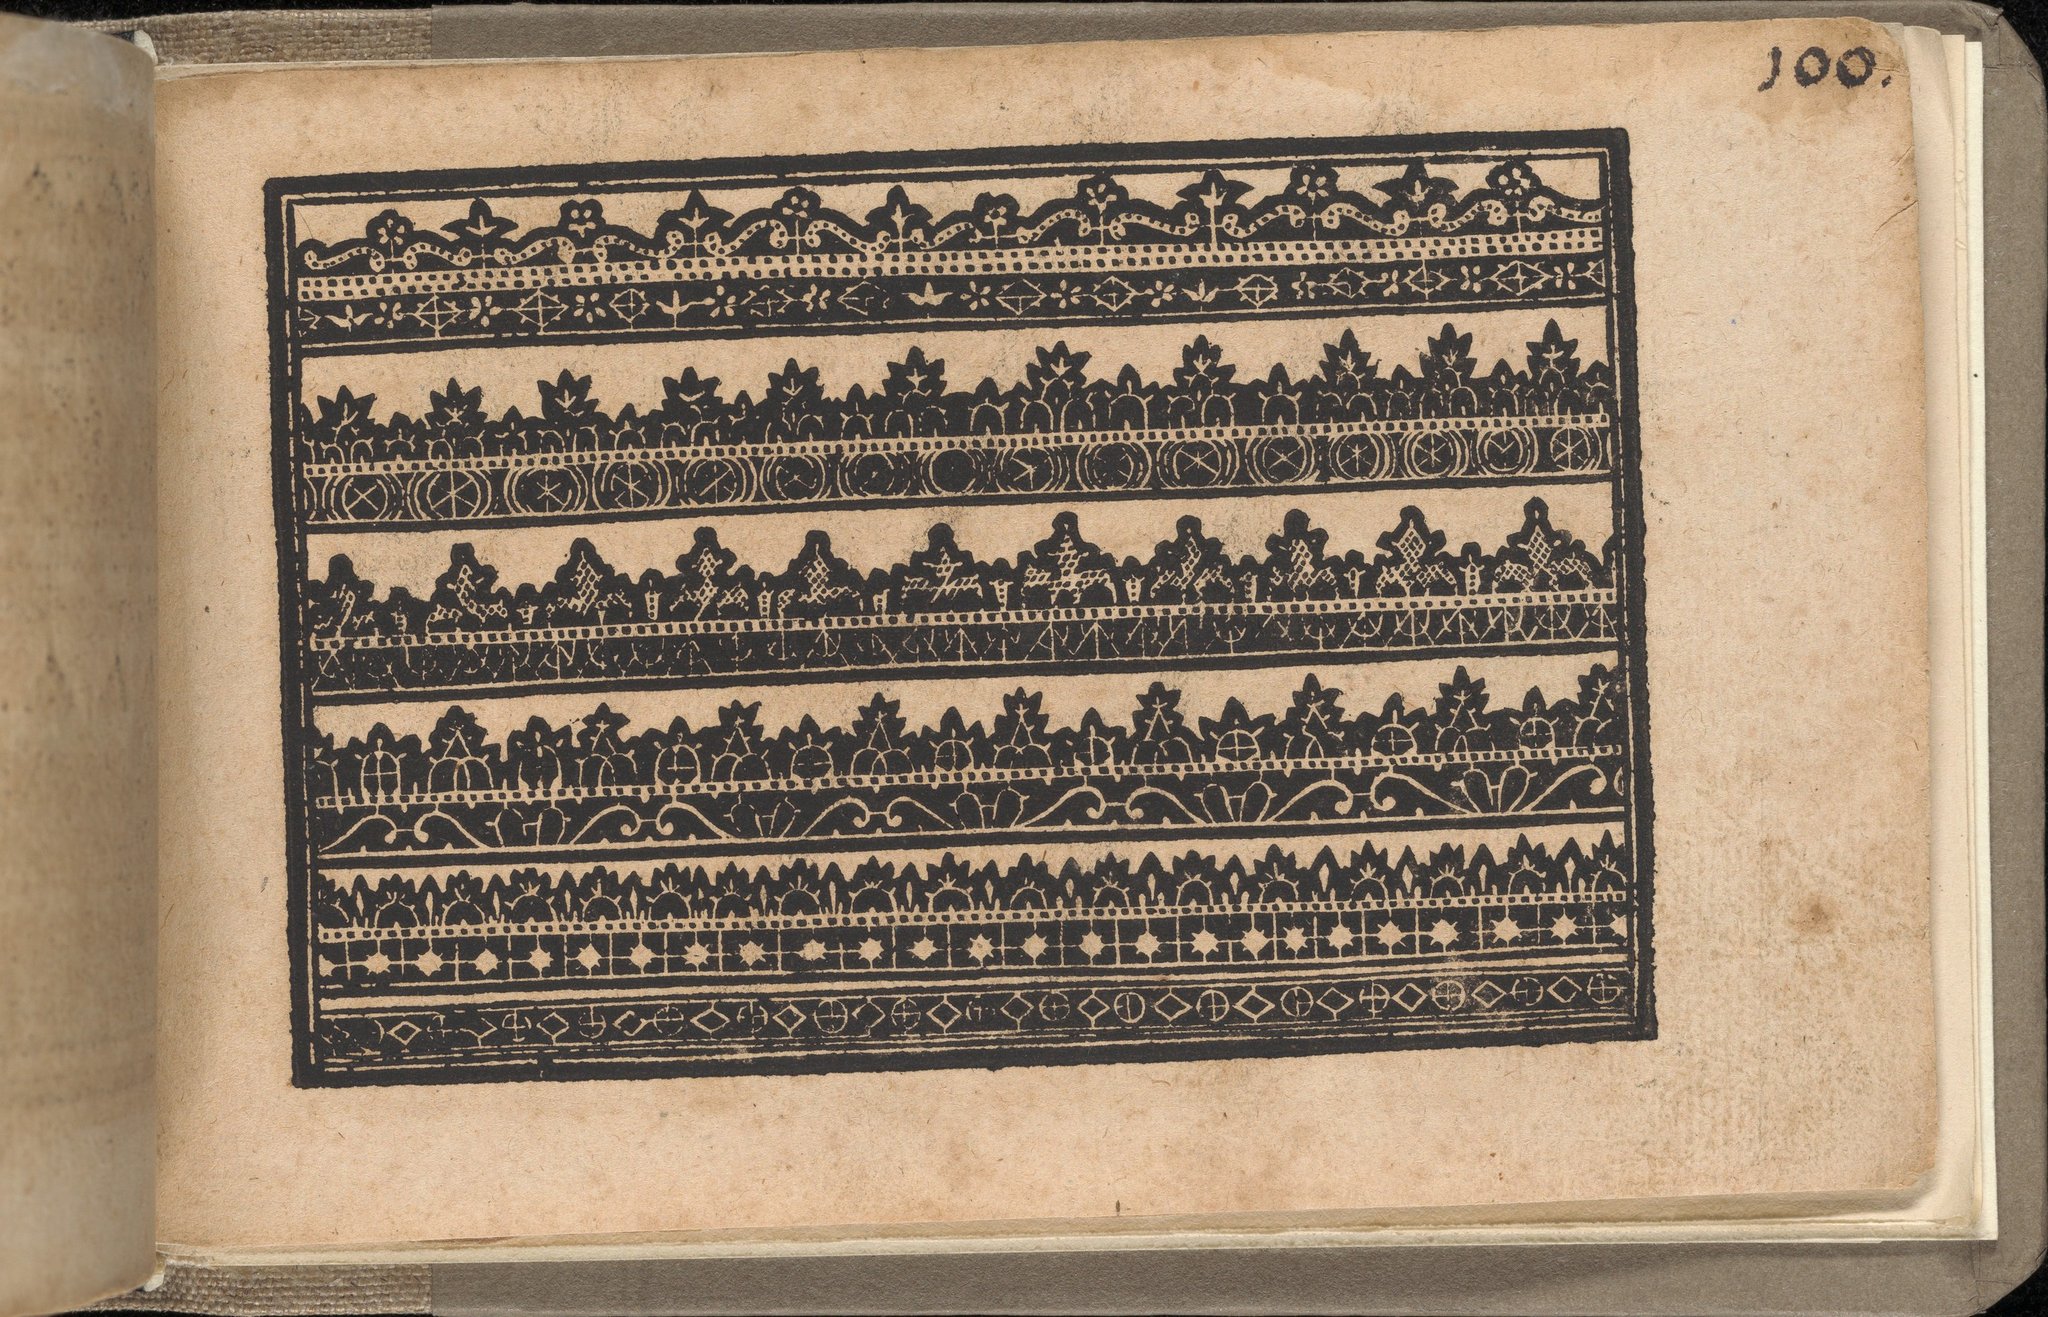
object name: book print ornament architecture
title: Schön newes Modelbuch (Page 100r)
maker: sigismundus latomus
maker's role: publisher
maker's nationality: german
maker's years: 1599-1632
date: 1608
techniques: woodcut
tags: ornament